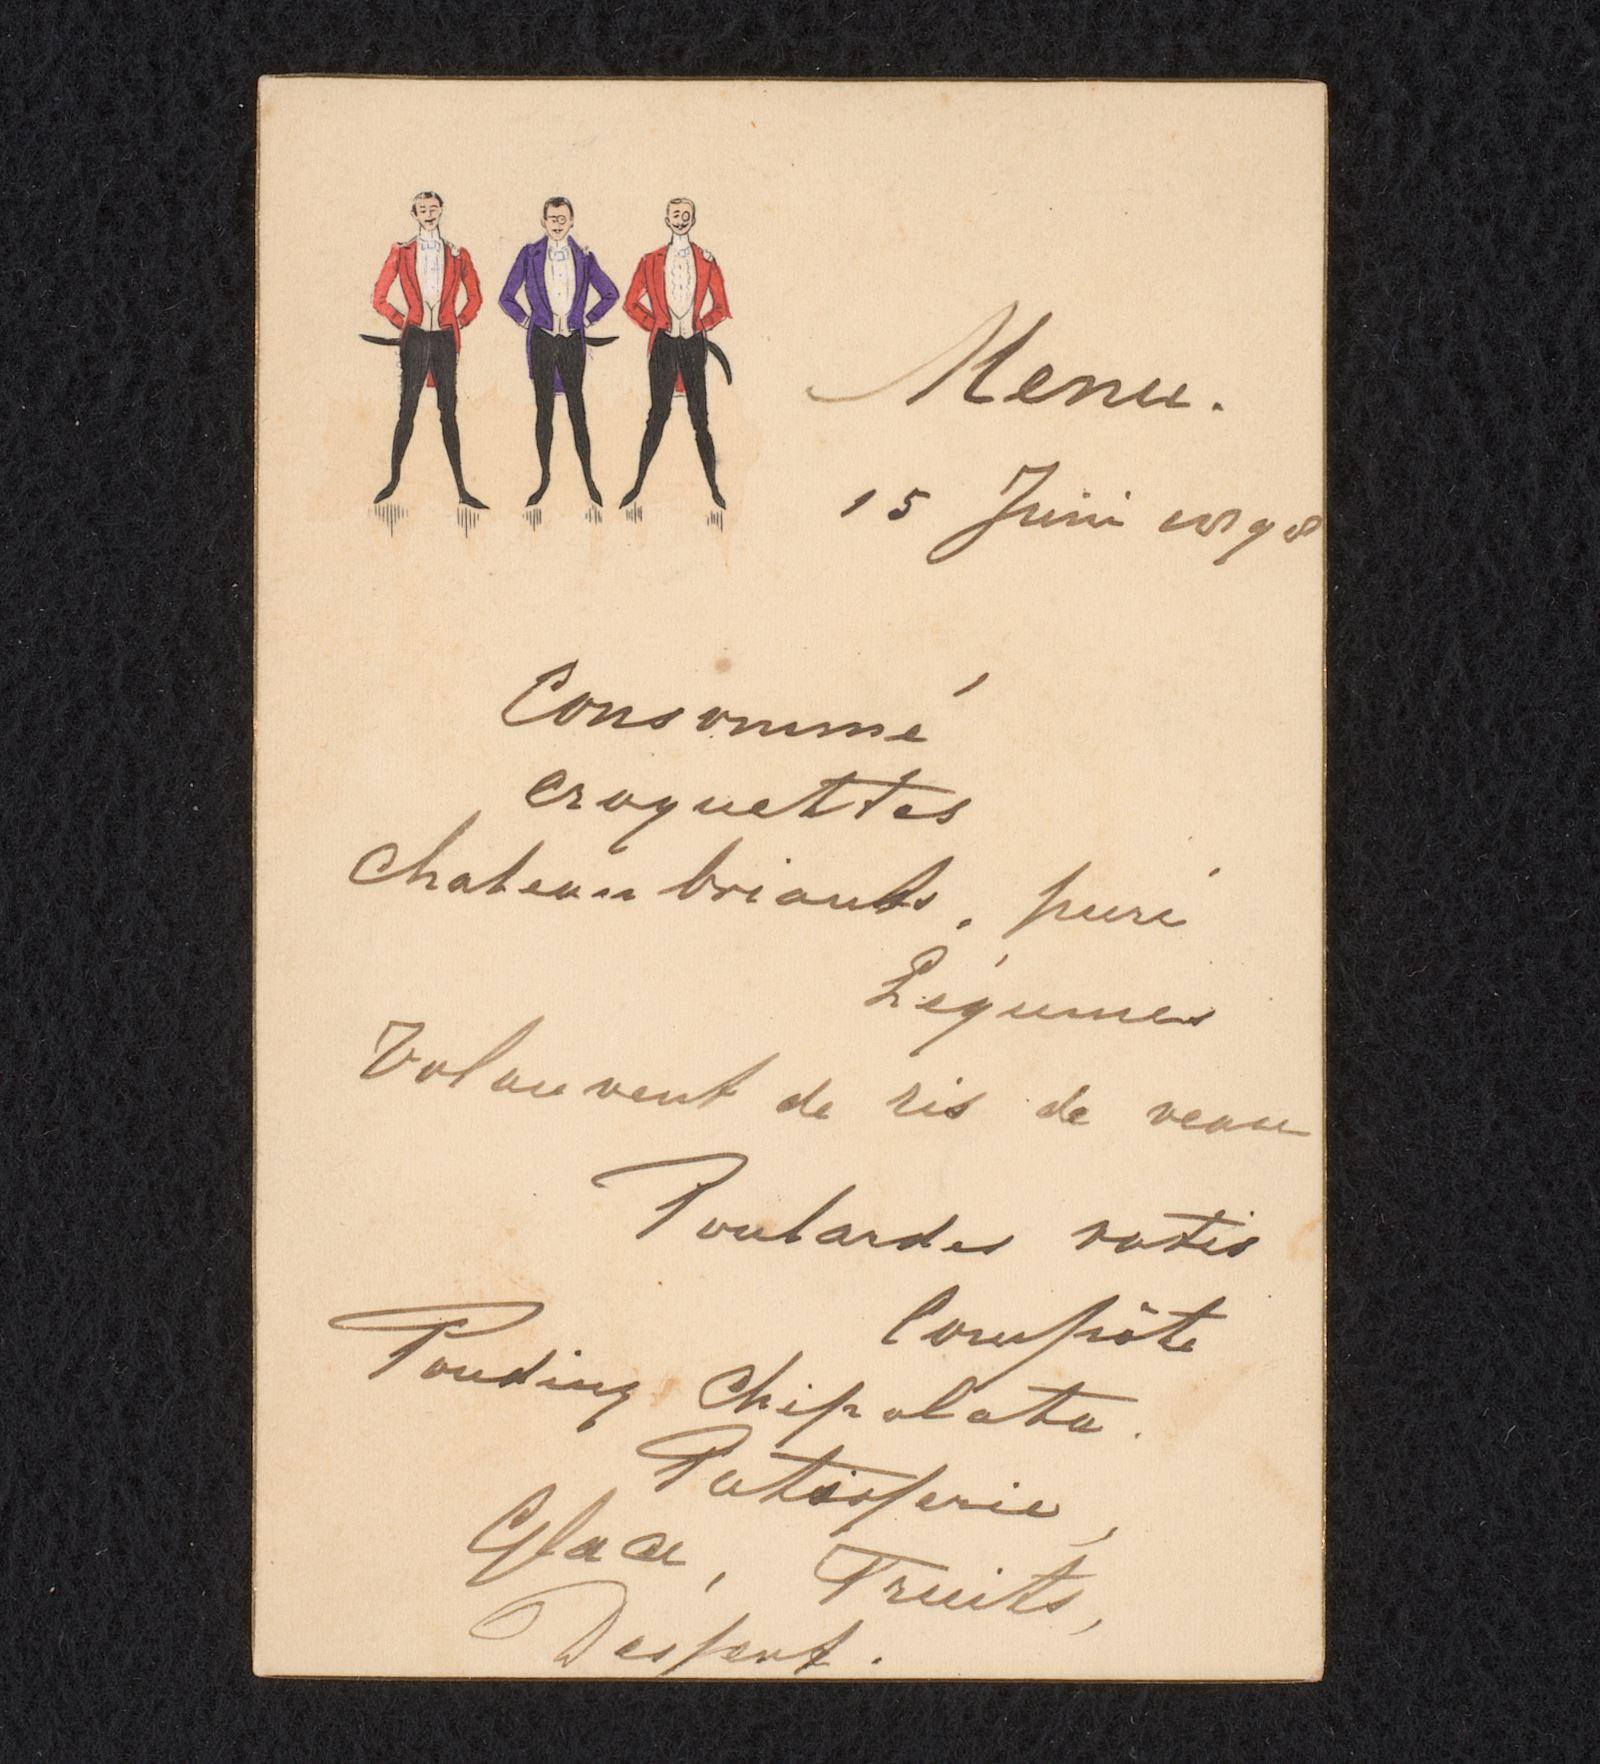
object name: drawing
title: Menukaart voor een diner op 15 juni 1898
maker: Anonymous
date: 1898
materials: paper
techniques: hand coloring, pen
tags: party clothes, festive attire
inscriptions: annotation: ‘Sche - M. van [...] - Mevr. Esche’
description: Bij gebrek aan gegevens over de vervaardiger is voor de bepaling van de rechten van dit object gebruik gemaakt van de vervaardigingsdatum.